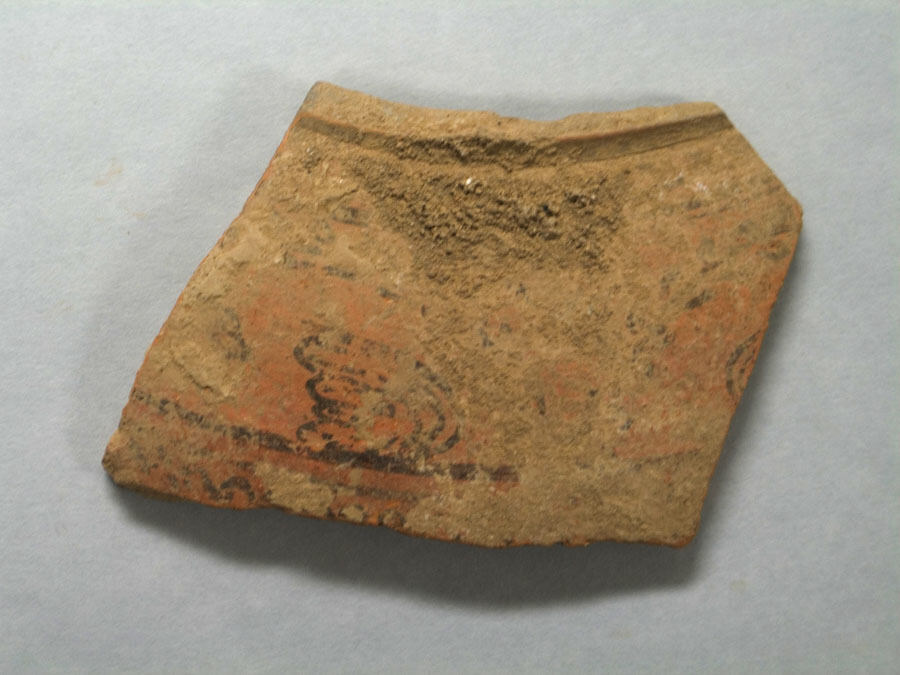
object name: shard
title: Shard: Shoulder of Vessel with Ornament of Mastif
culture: pakistani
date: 301-500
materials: terracotta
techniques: painting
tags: gandhara